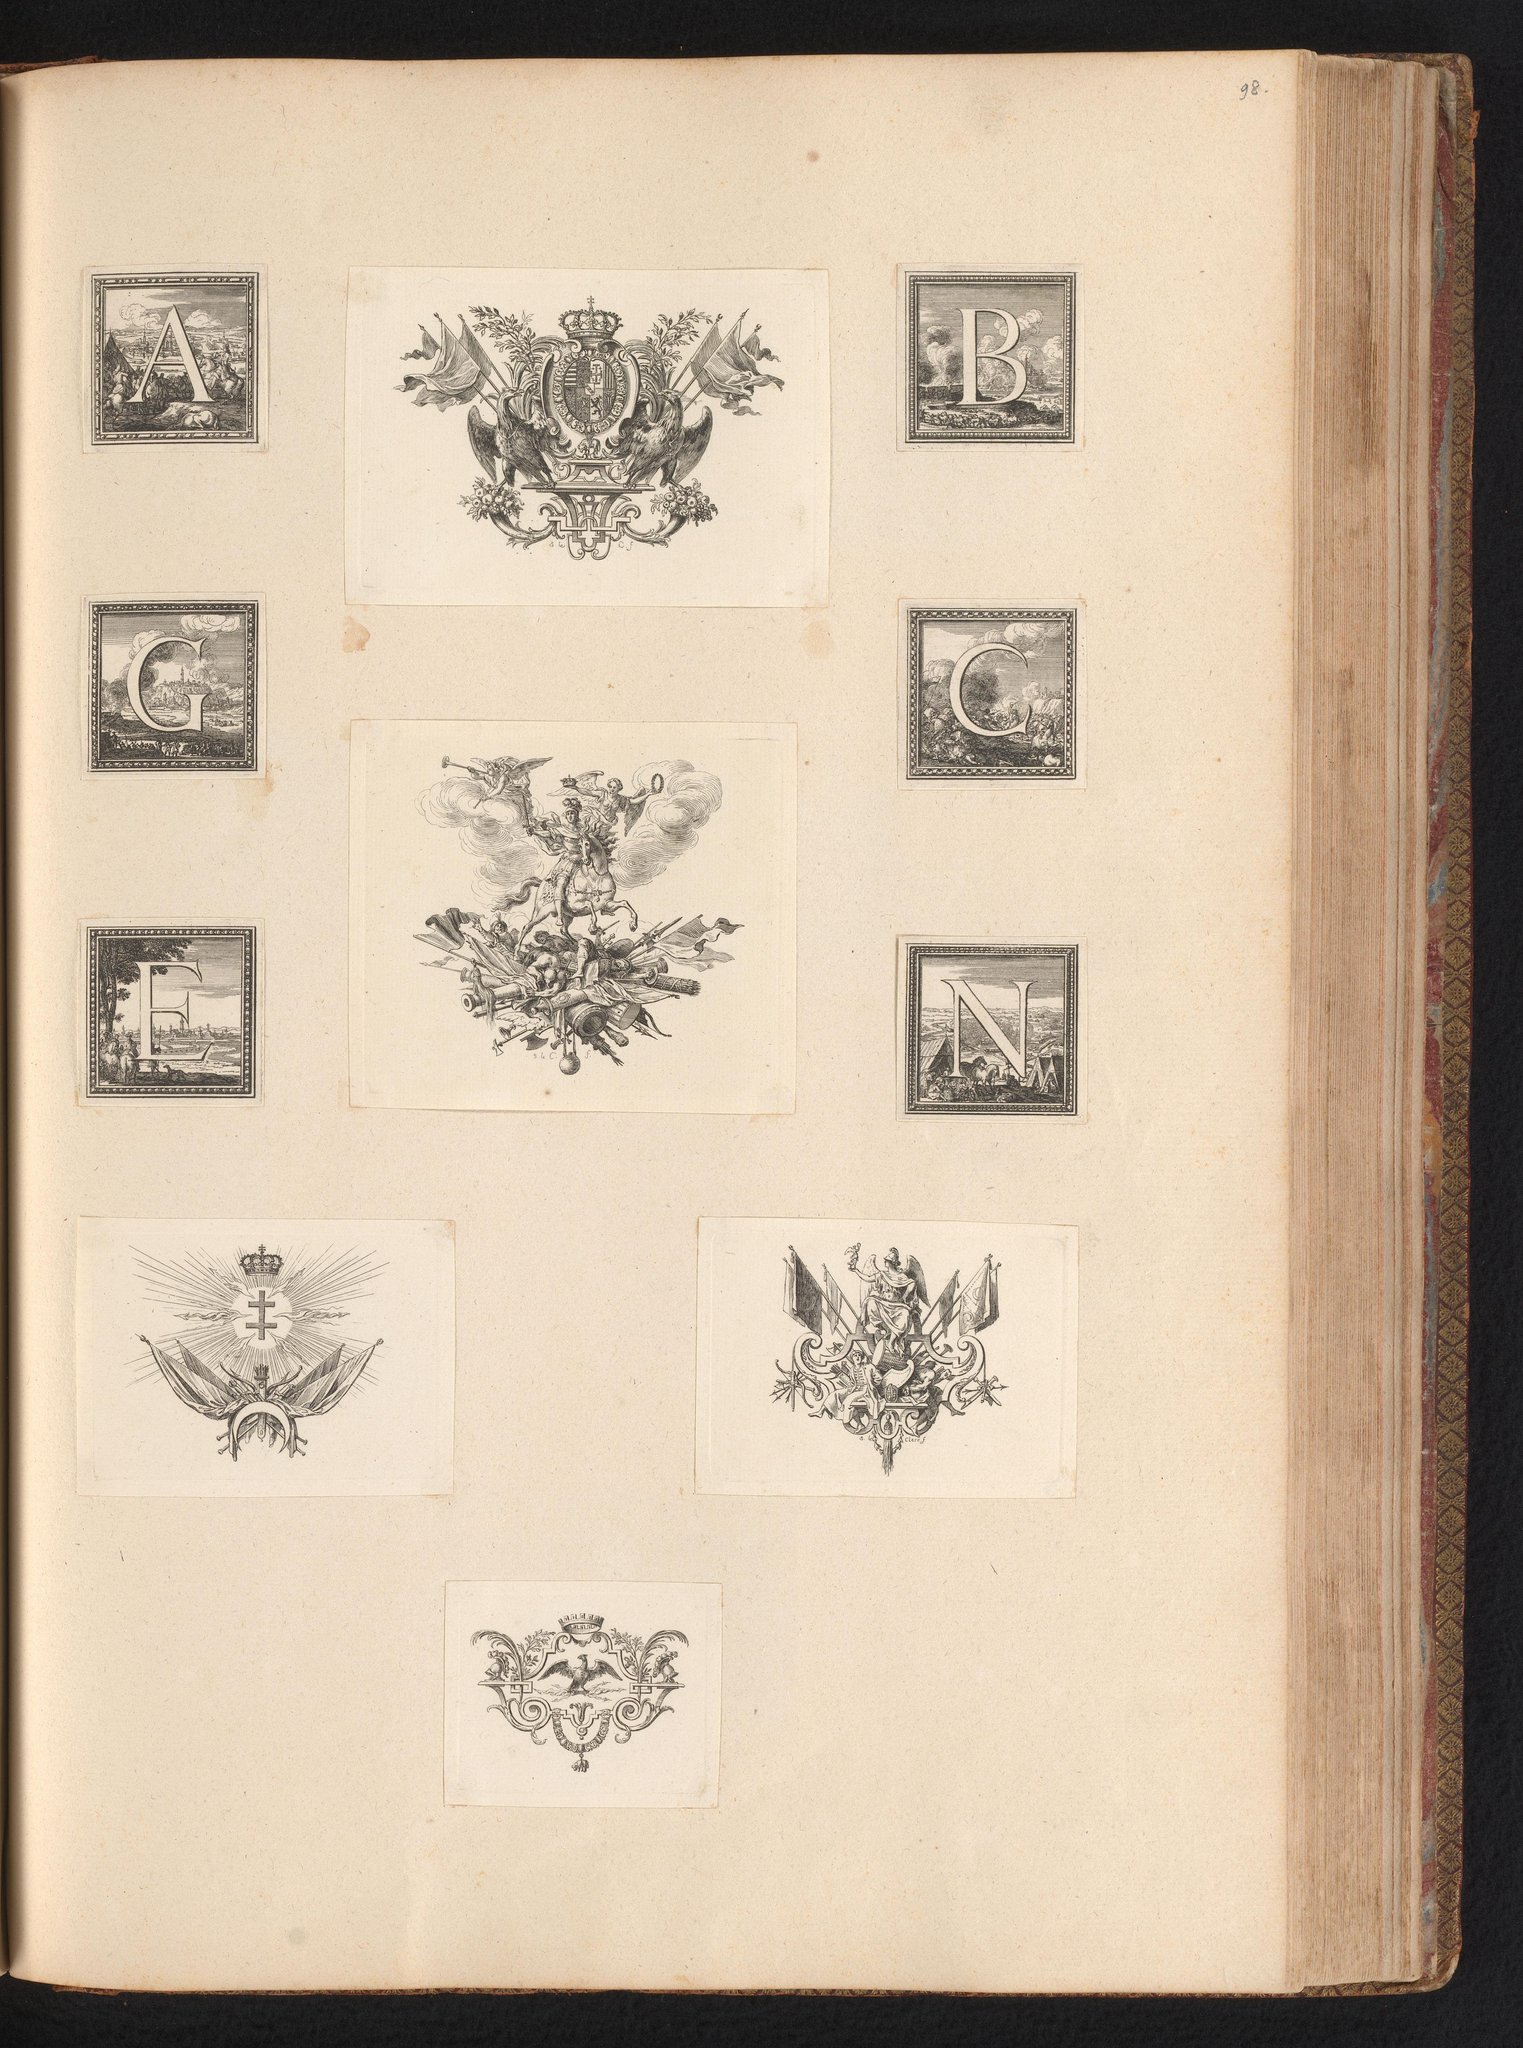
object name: album leaf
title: Vijf cul-de-lampes en zes initialen met betrekking tot Karel V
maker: sébastien leclerc (i)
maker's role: print maker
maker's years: 1637-1714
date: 1703-1704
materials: paper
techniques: etching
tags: initial, historical persons, king, armorial bearing, heraldry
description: Deze elf prenten maken deel uit van een serie met 37 prenten met scènes uit het leven van Karel V, koning van Frankrijk.